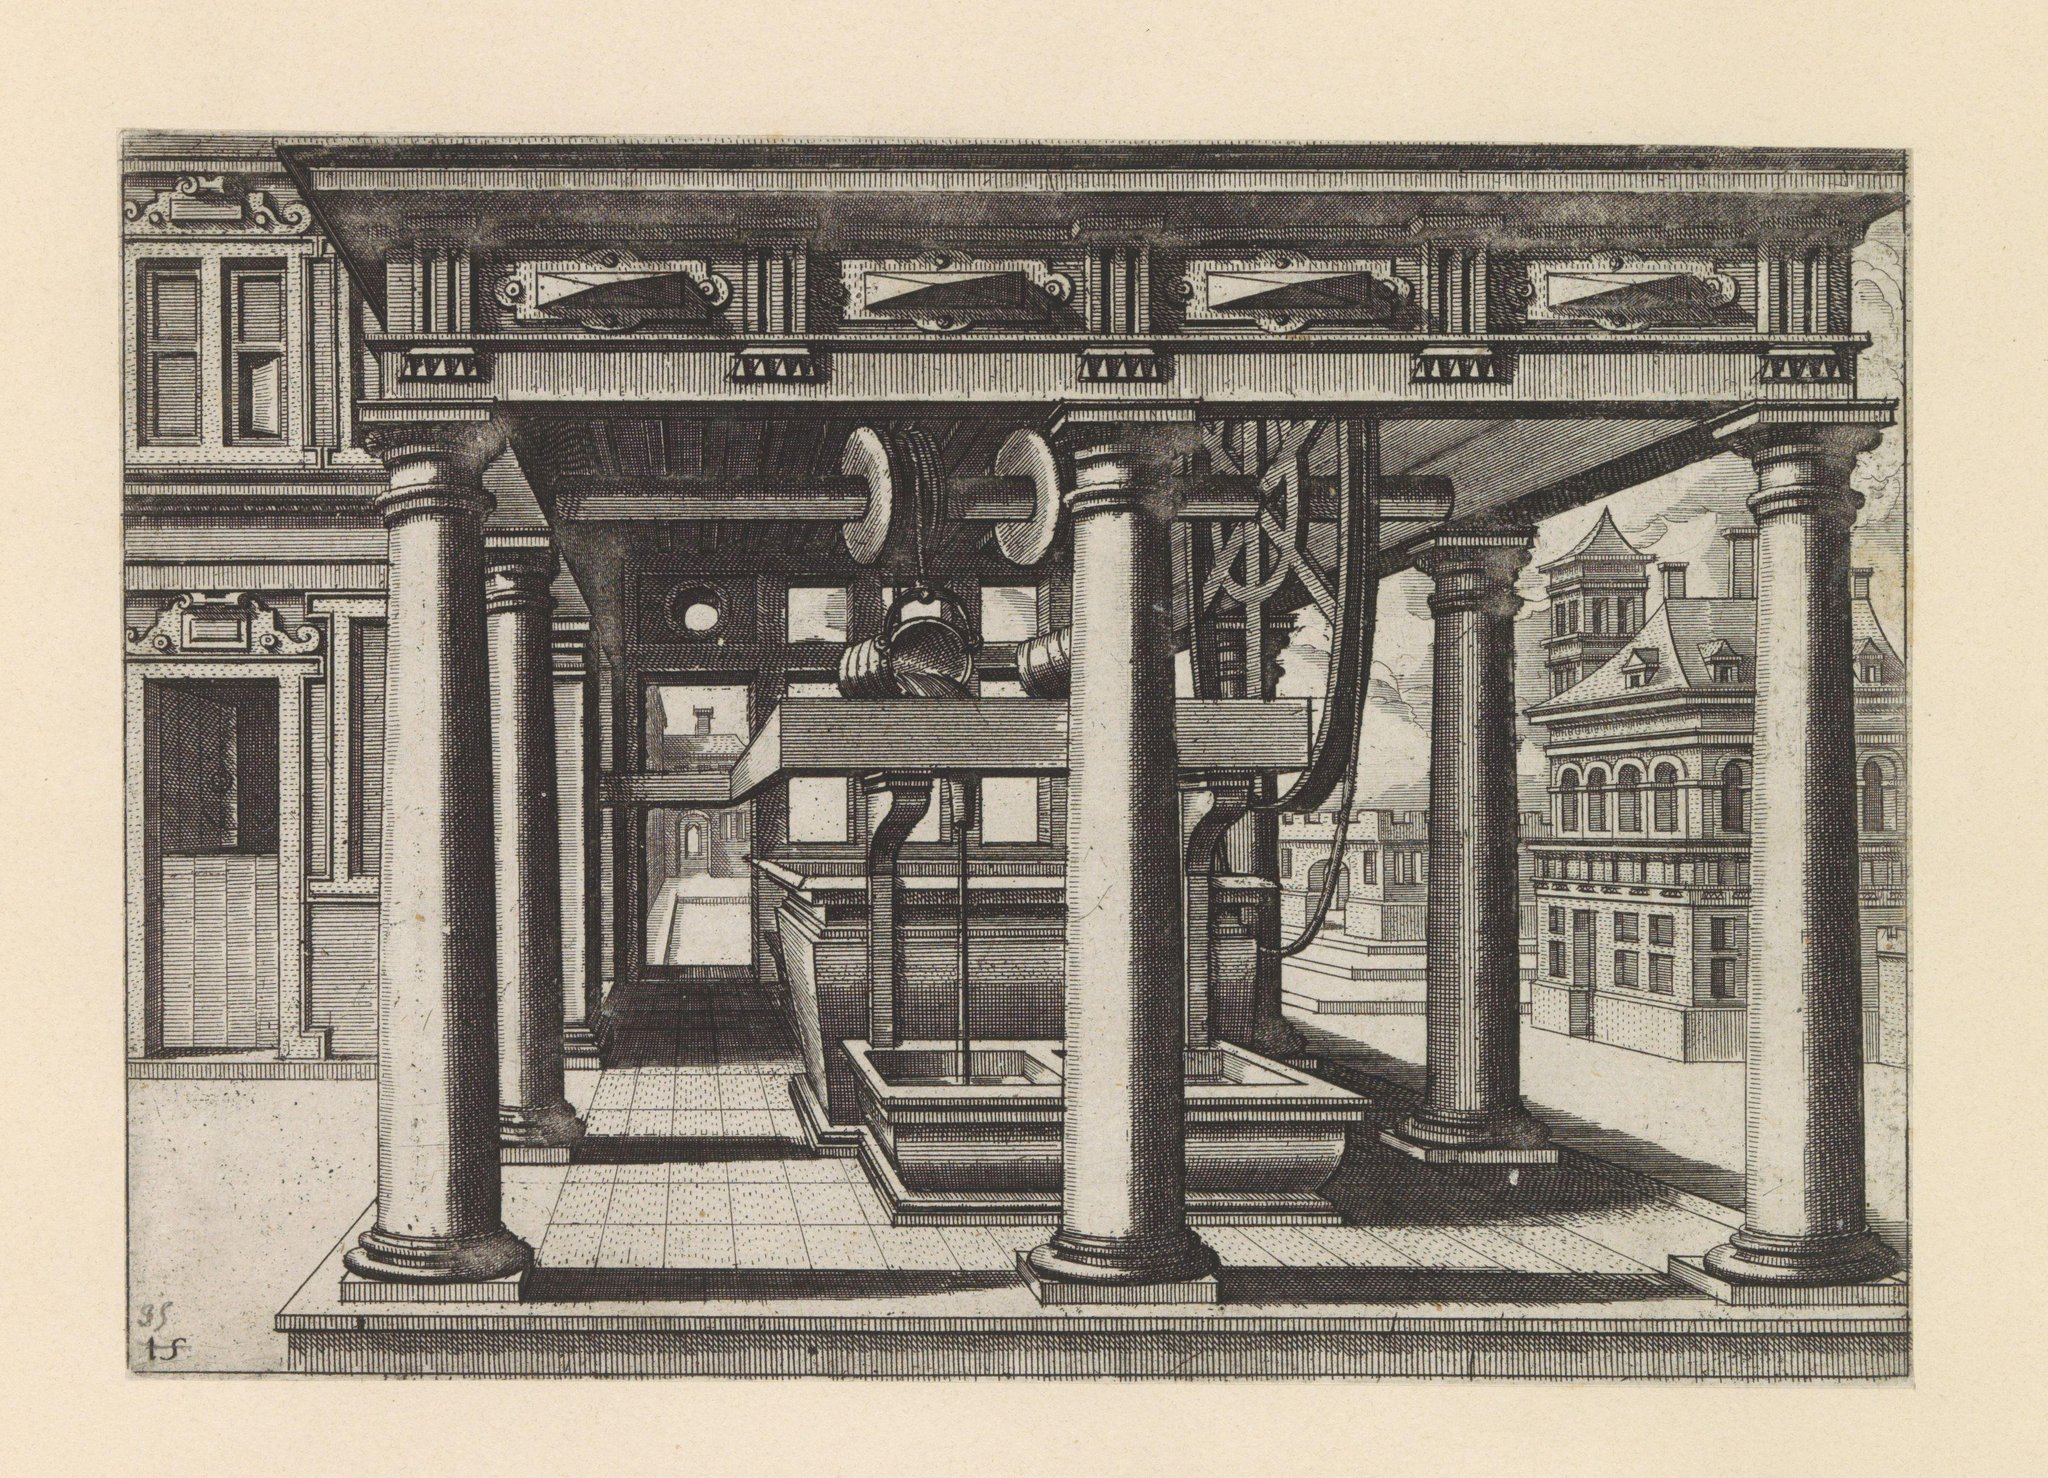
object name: album leaf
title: Waterput onder colonnade met Toscaanse zuilen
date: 1574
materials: paper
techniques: etching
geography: antwerp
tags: well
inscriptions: inscription: ‘35’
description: Onder een colonnade met Toscaanse zuilen staat een rechthoekige waterput op een betegelde verhoging. Rechts een gezicht op een stadsplein. De prent maakt deel uit van een album.